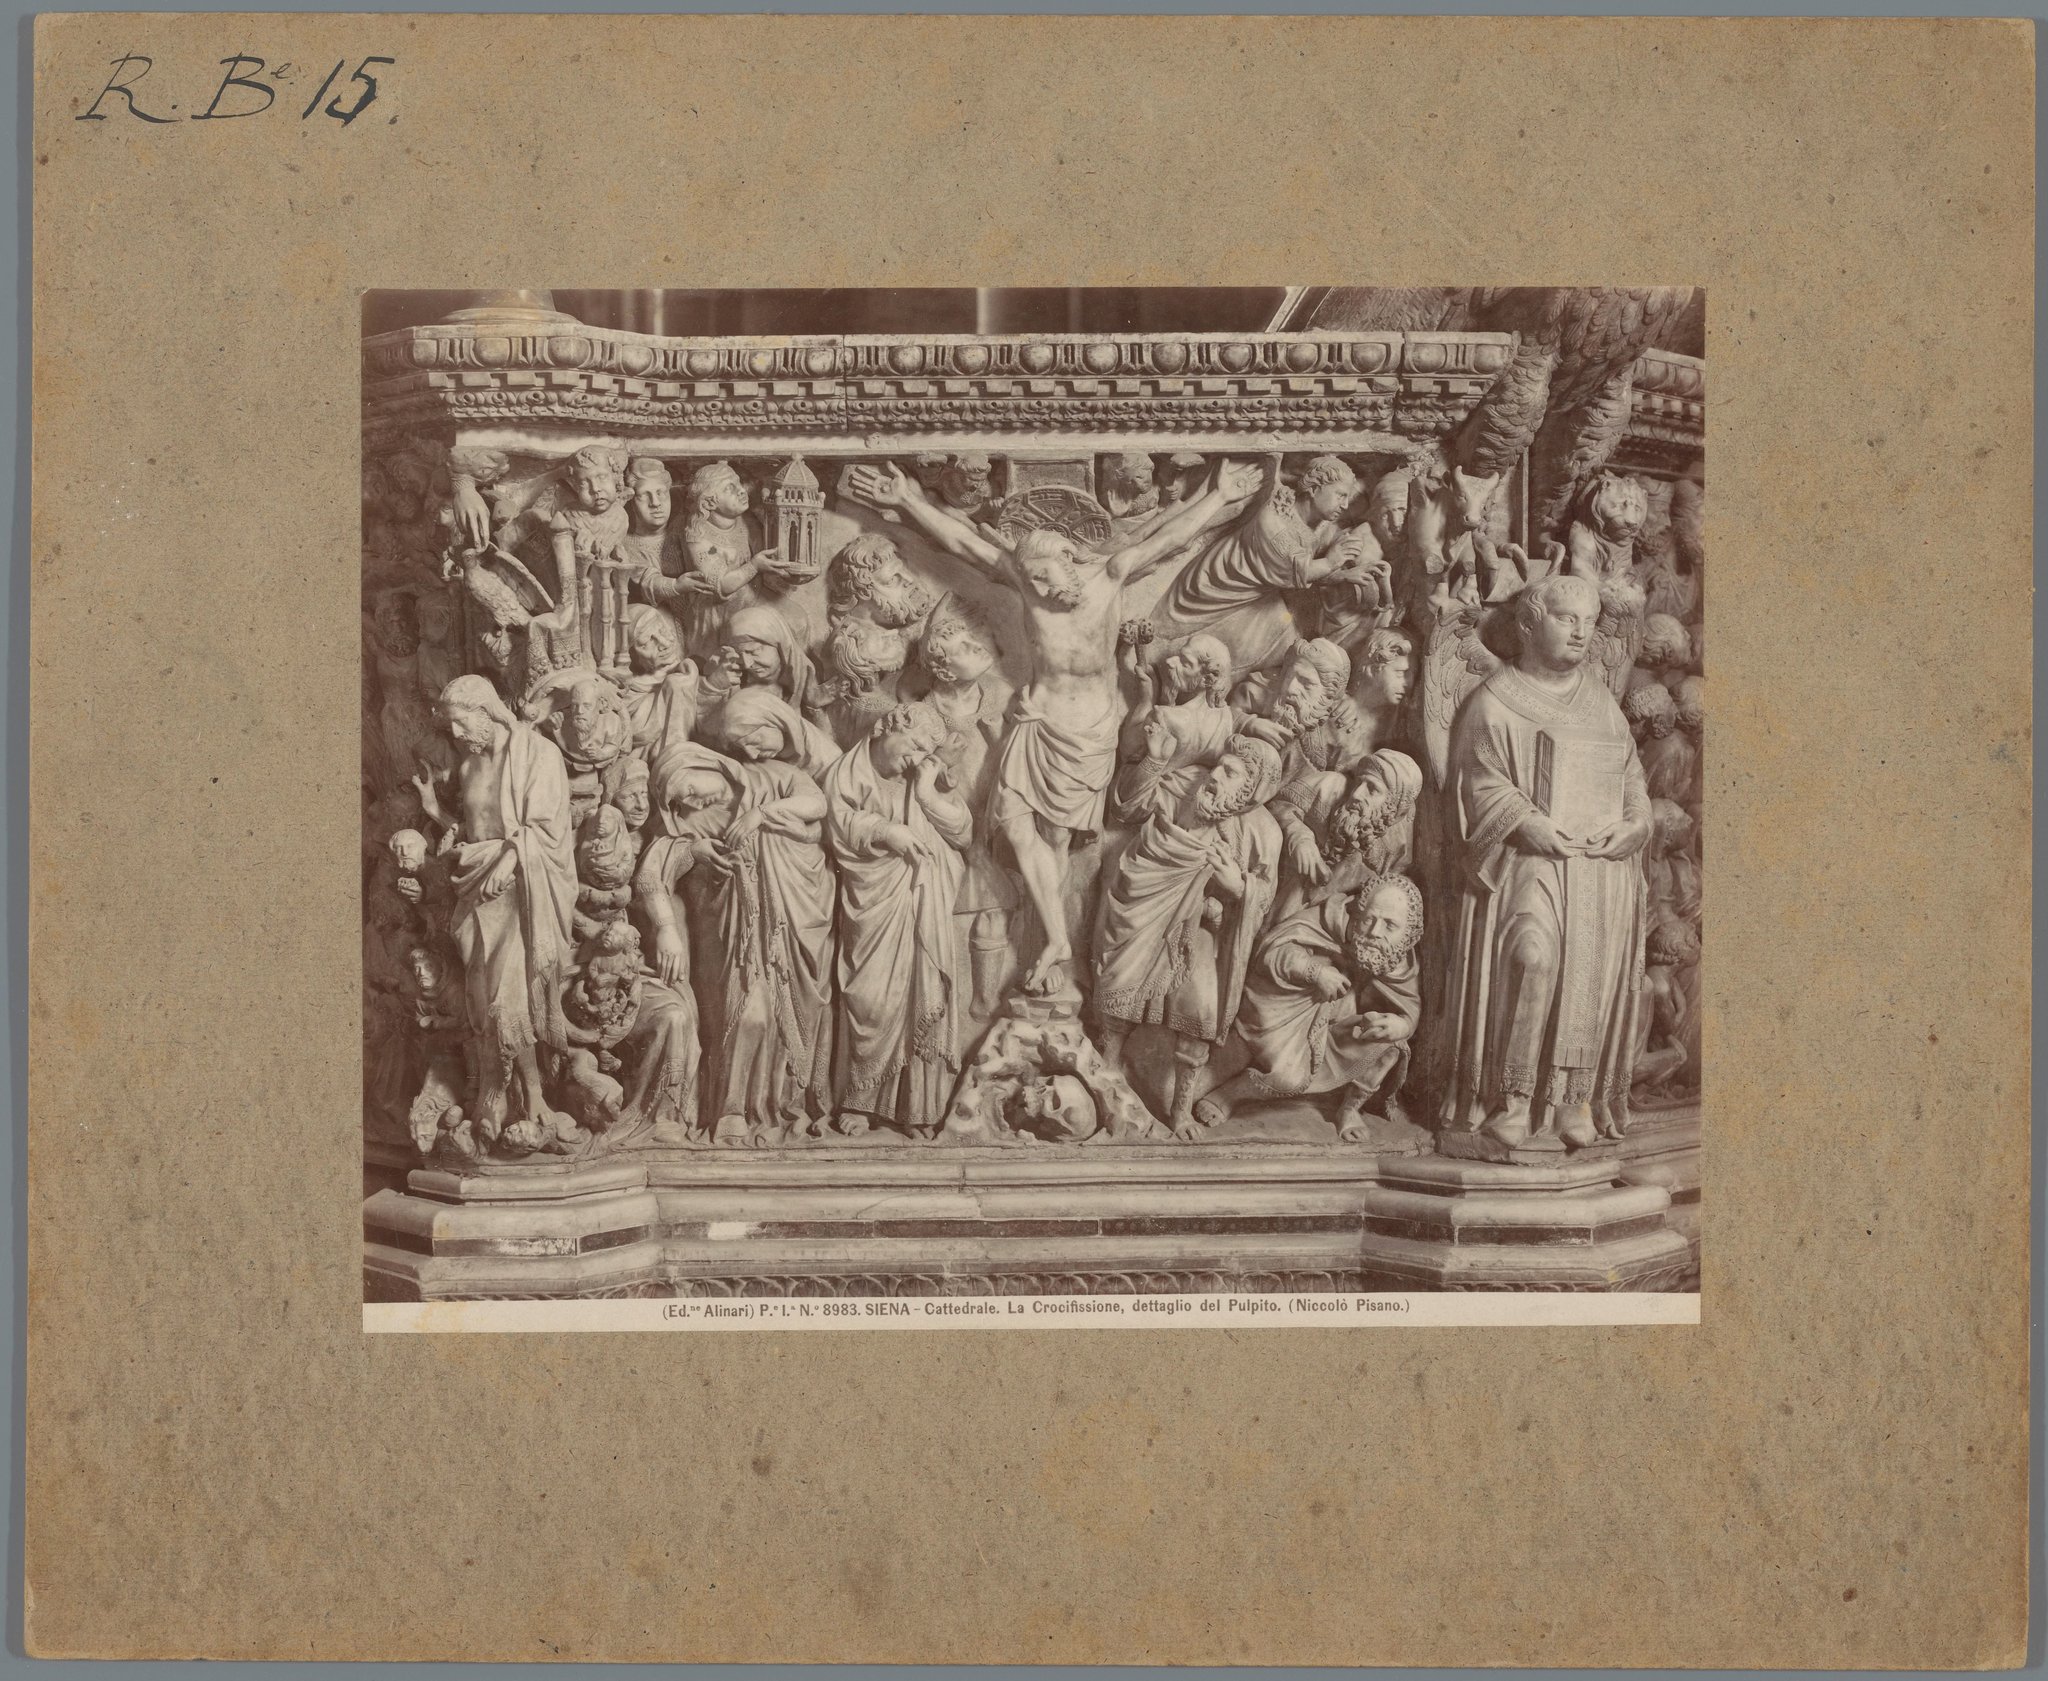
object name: photograph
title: SIENA - Cattedrale. La Crocifissione, dettaglio del Pulpito.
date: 1875-1900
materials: cardboard, photographic support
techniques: albumen print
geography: siena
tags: interior of church, pulpit, ambo, chancel, the crucifixion of christ: christ's death on the cross; golgotha (matthew 27:45-58; mark 15:33-45; luke 23:44-52; john 19:25-38), sculpture (+ relief ~ sculpture)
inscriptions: collector's mark: Lugt 3937, number: ‘P.e 2.a N.o 8983.’